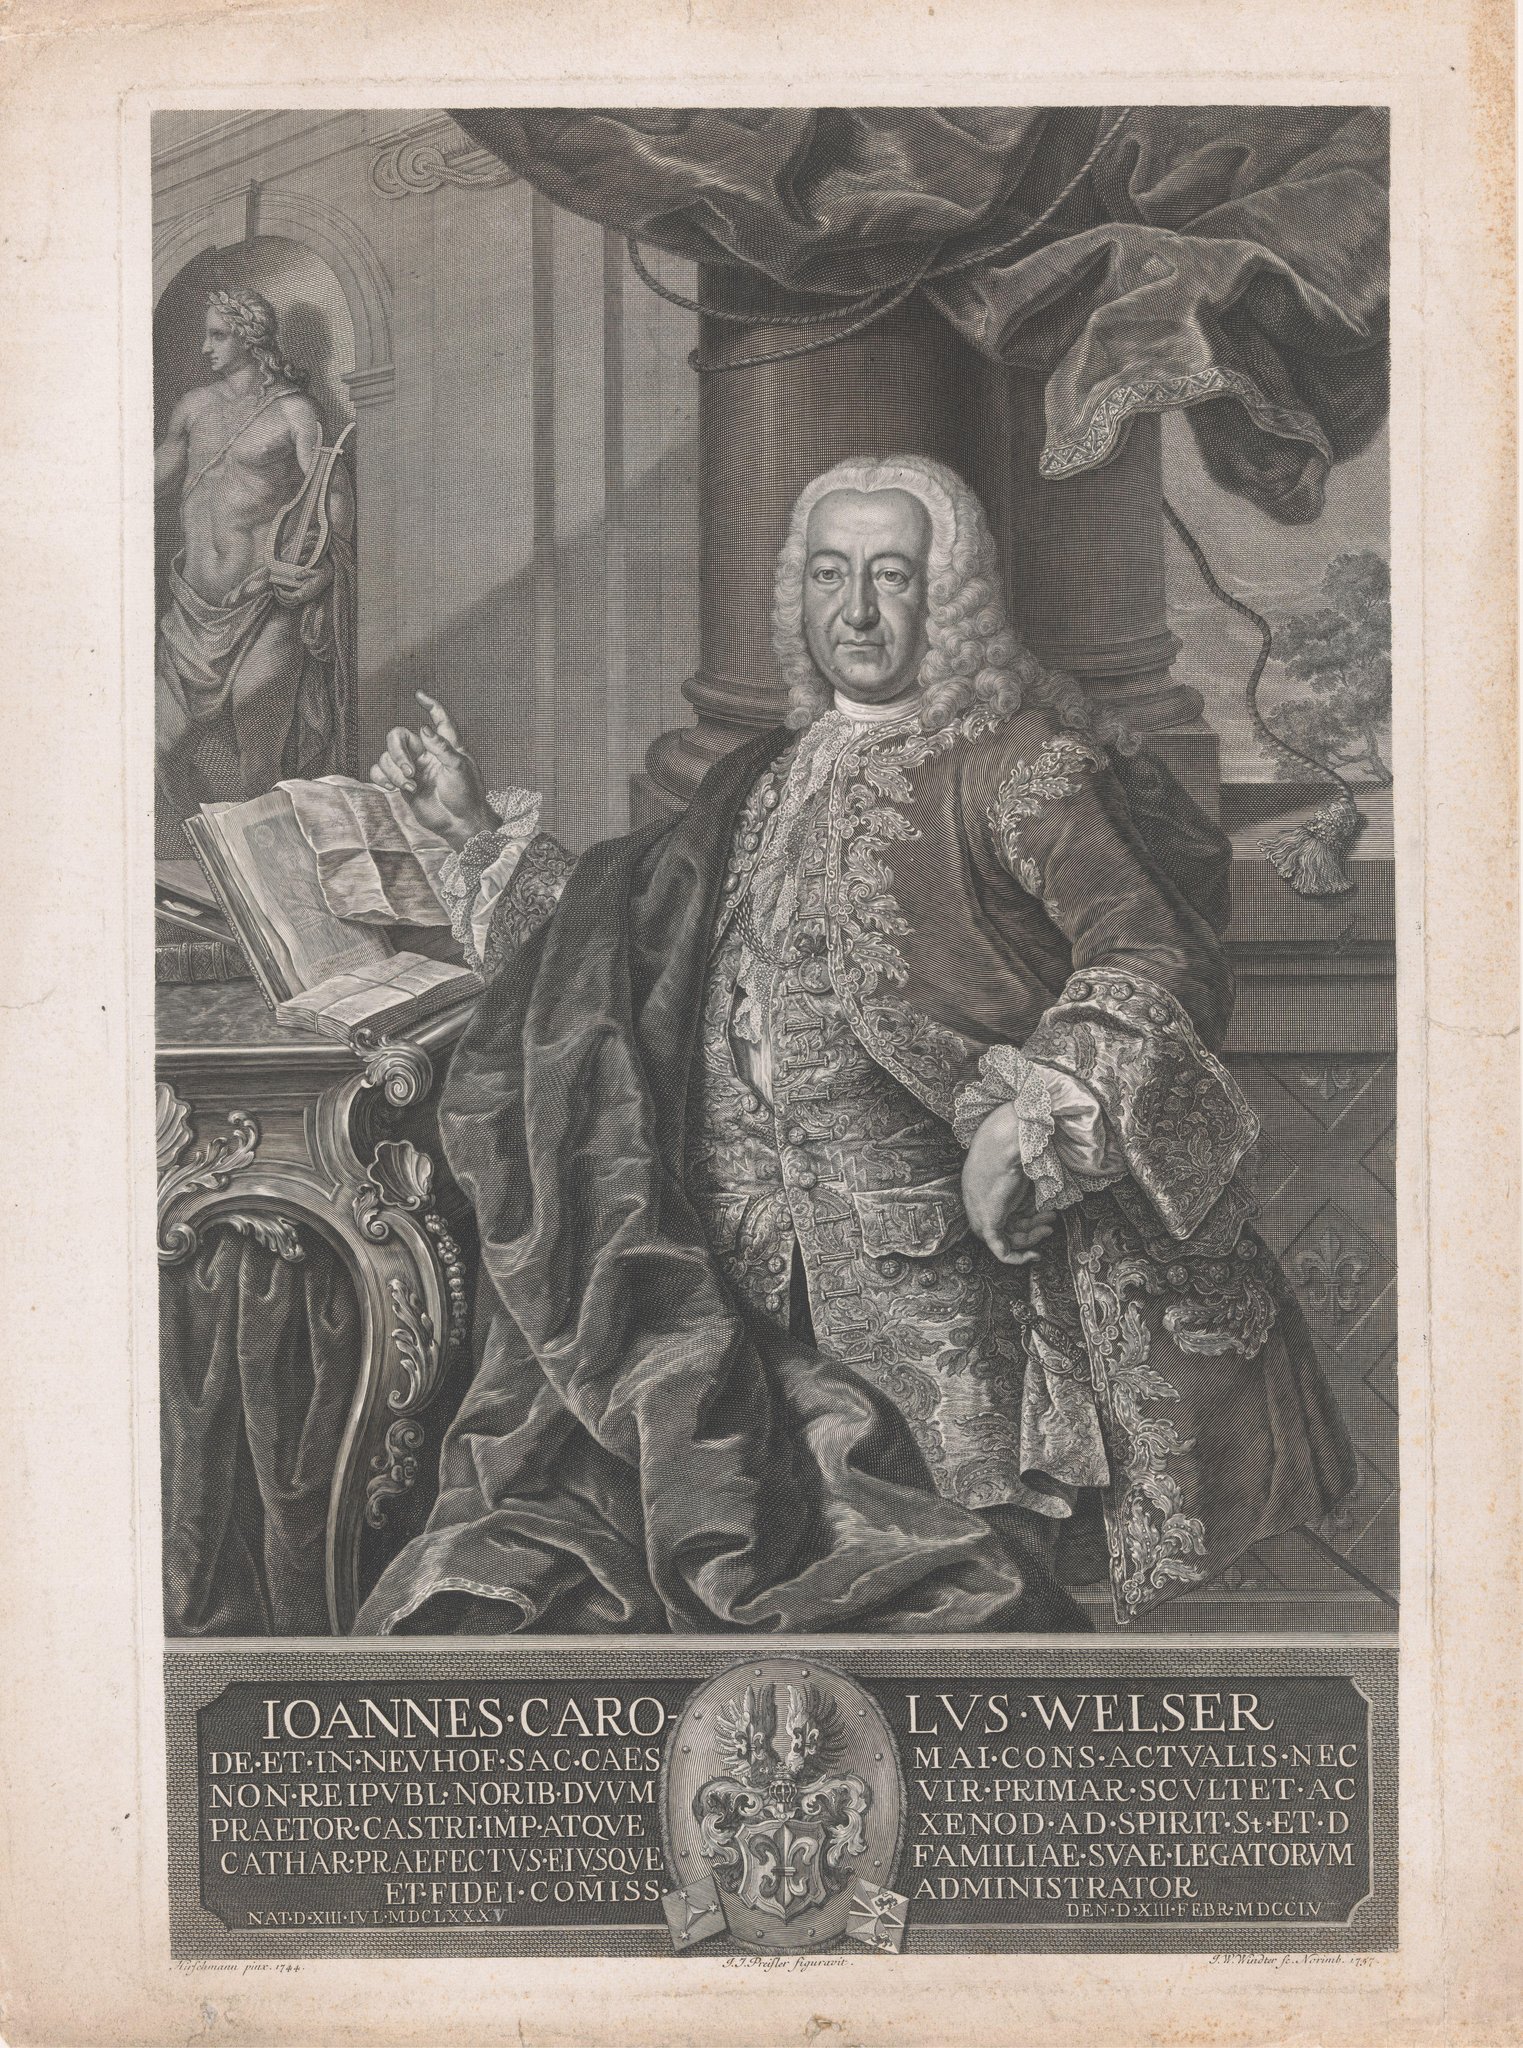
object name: print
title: Portret van Johann Karl Welser von Neunhof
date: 1757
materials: paper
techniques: engraving, etching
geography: nuremberg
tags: mayor, historical persons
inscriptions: collector's mark: Lugt 2228